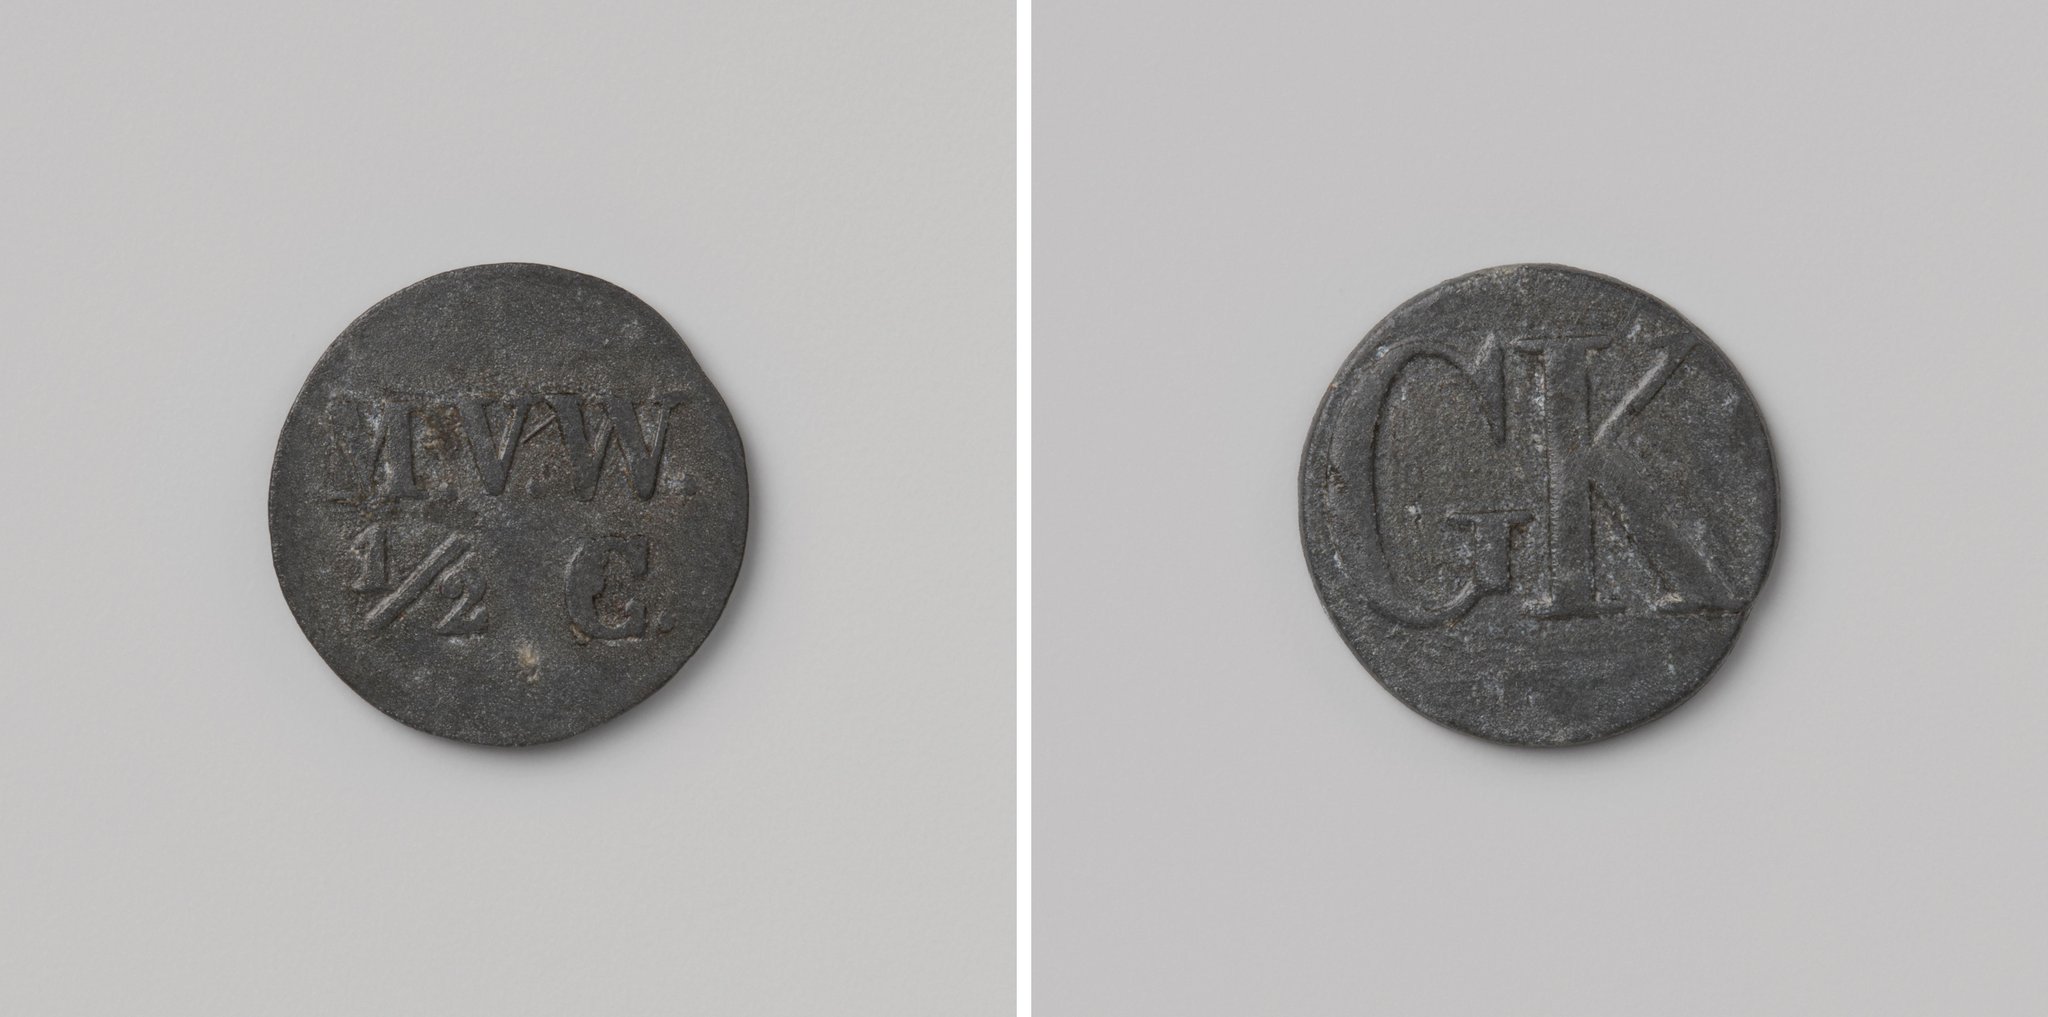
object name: huismunt prison money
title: Huismunt ter waarde van een halve cent, geslagen op last van de Maatschappij van Weldadigheid ten behoeve van de Gewone Koloniën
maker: Anonymous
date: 1818-1859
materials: zinc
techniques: striking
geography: netherlands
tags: maatschappij van weldadigheid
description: Zinken munt. Voorzijde: opschrift boven waardeaanduiding. Keerzijde: opschrift G en K